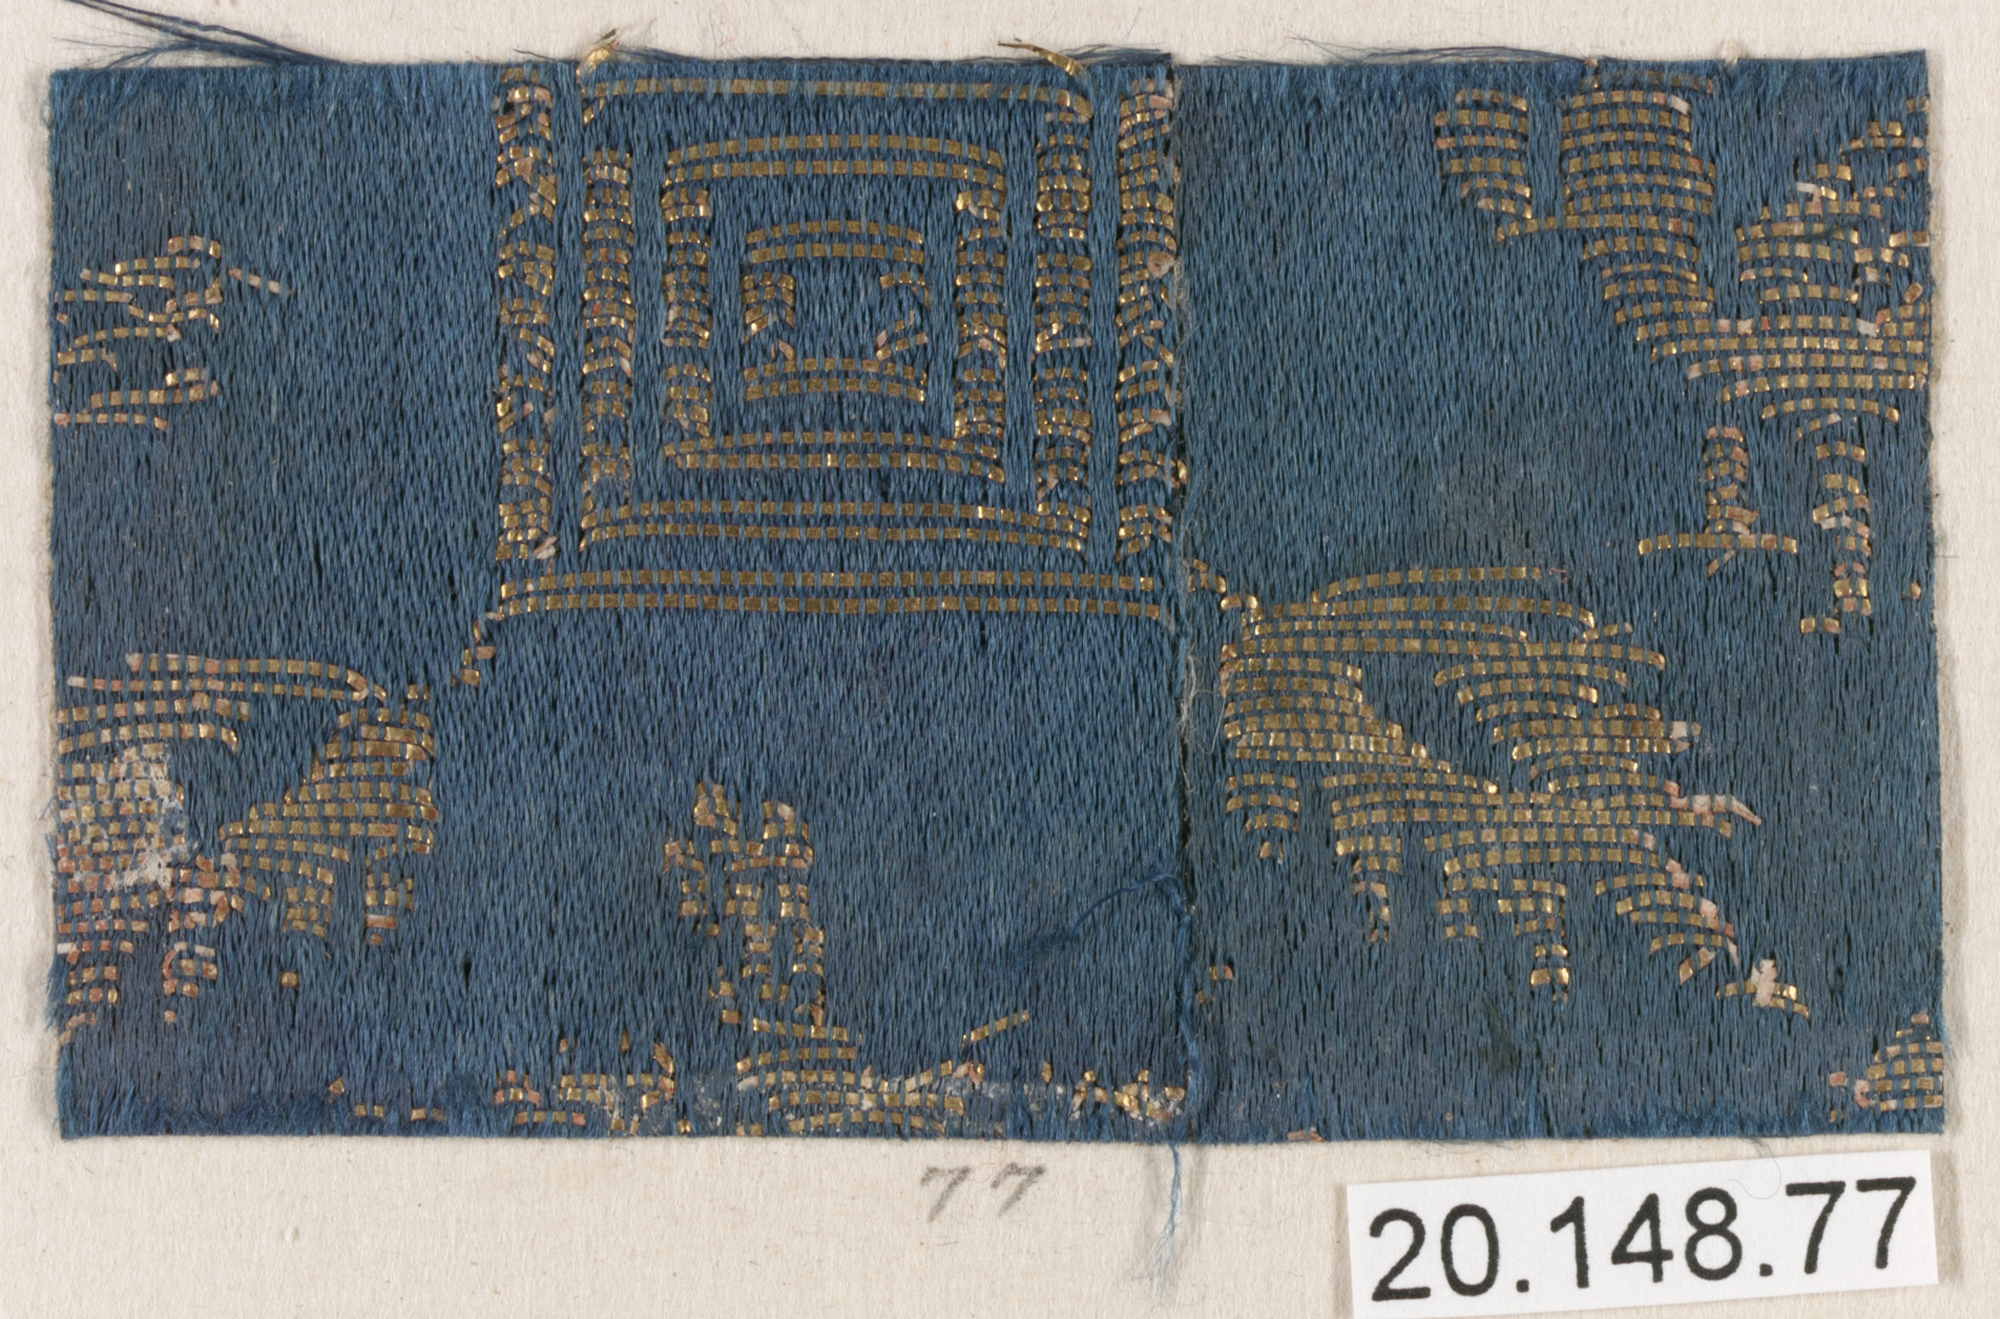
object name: piece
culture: japanese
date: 1601-1700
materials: silk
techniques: compound weave